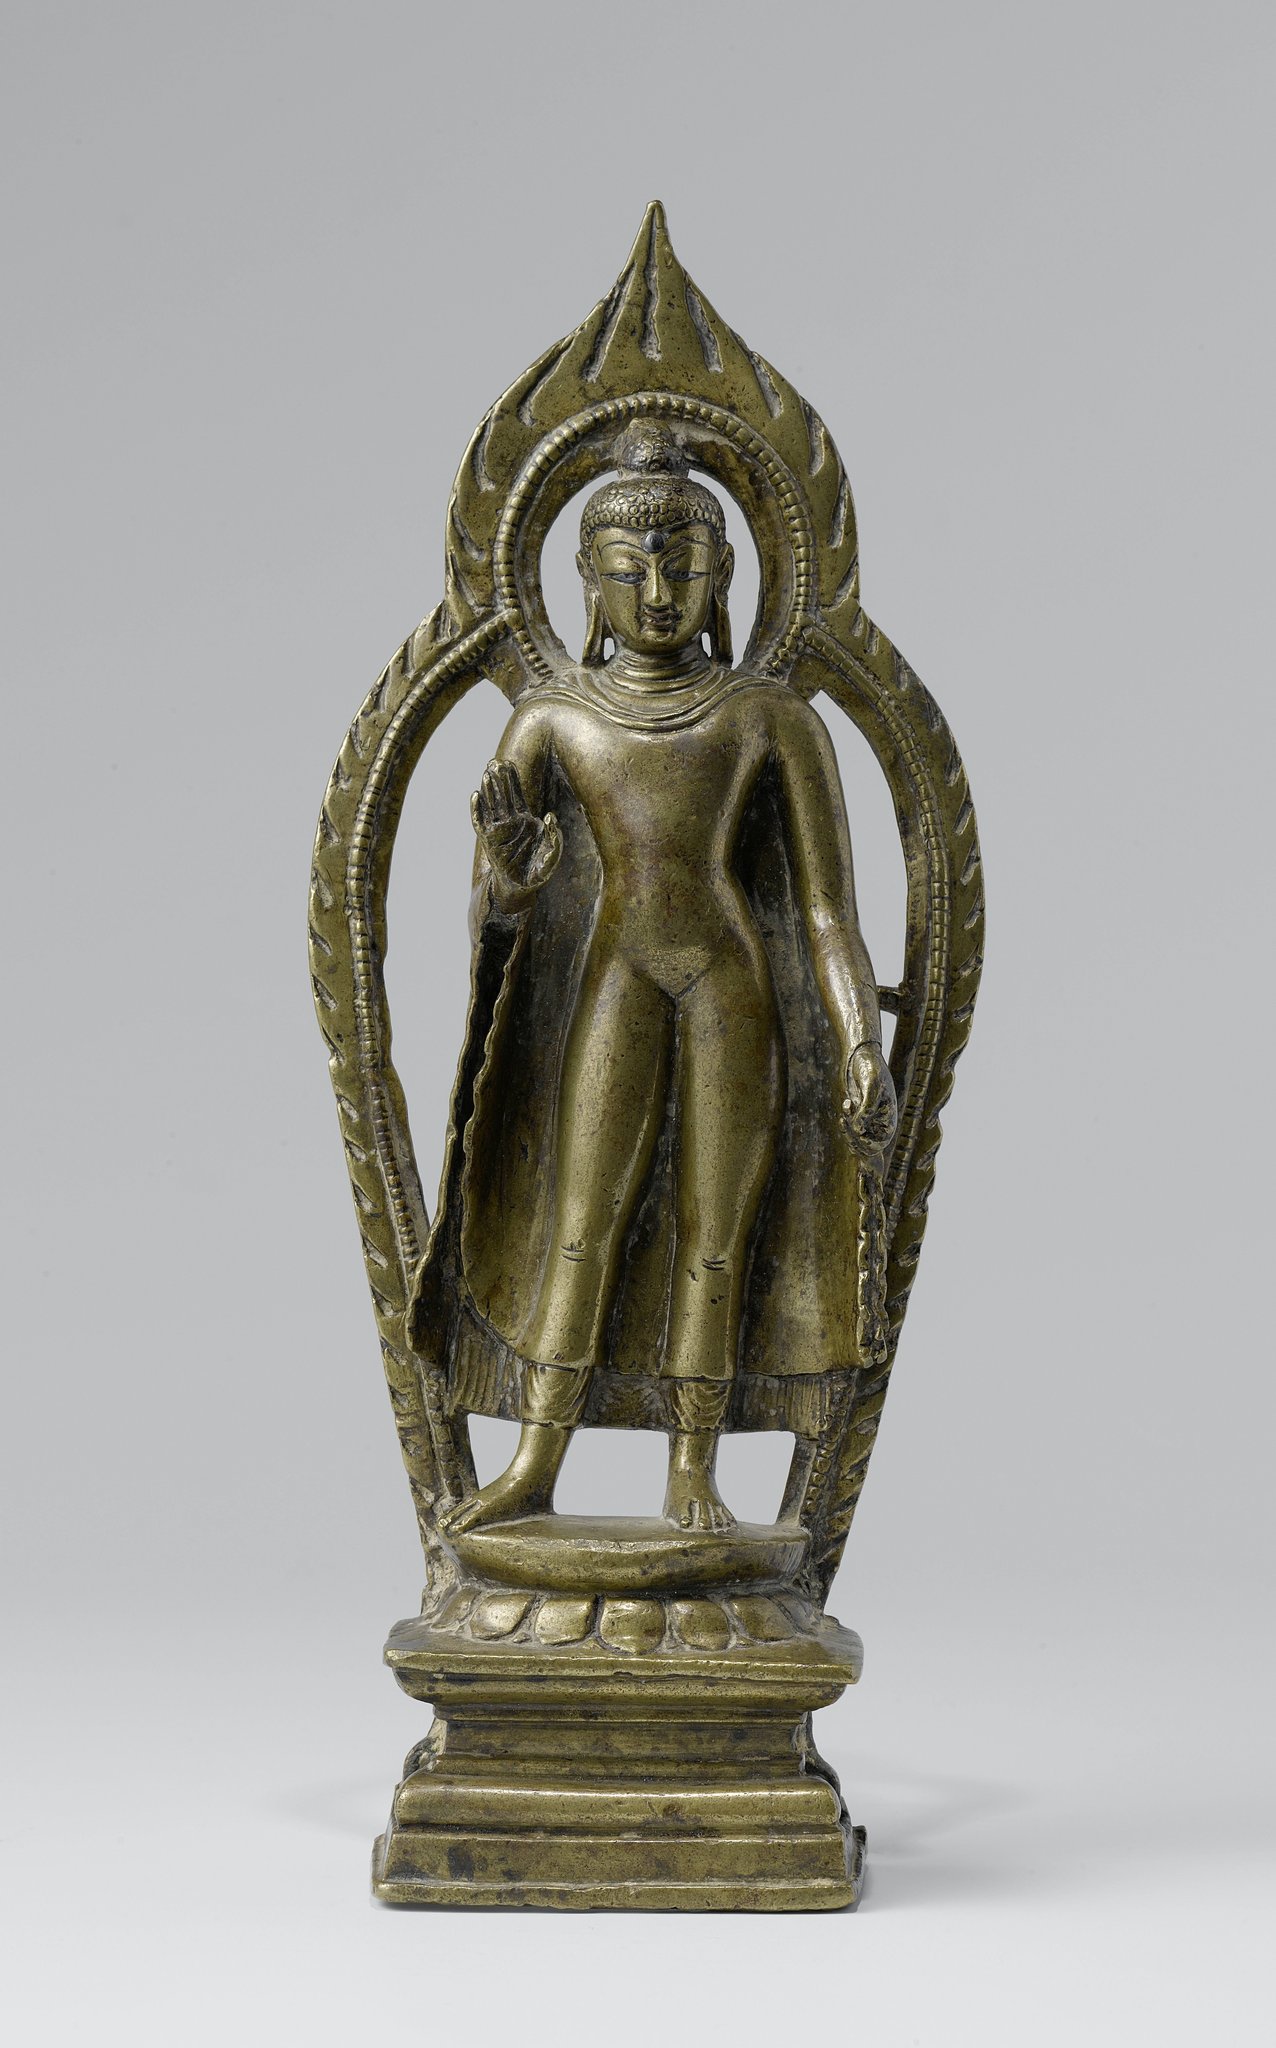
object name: boeddha kop, boeddha beeld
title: Buddha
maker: Anonymous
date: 800-1000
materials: brass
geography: jammu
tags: buddha, founder of buddhism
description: Gautama Boeddha staande op Lotuskussen; klein vlammenaureool om het hoofd en een groot om het lichaam.